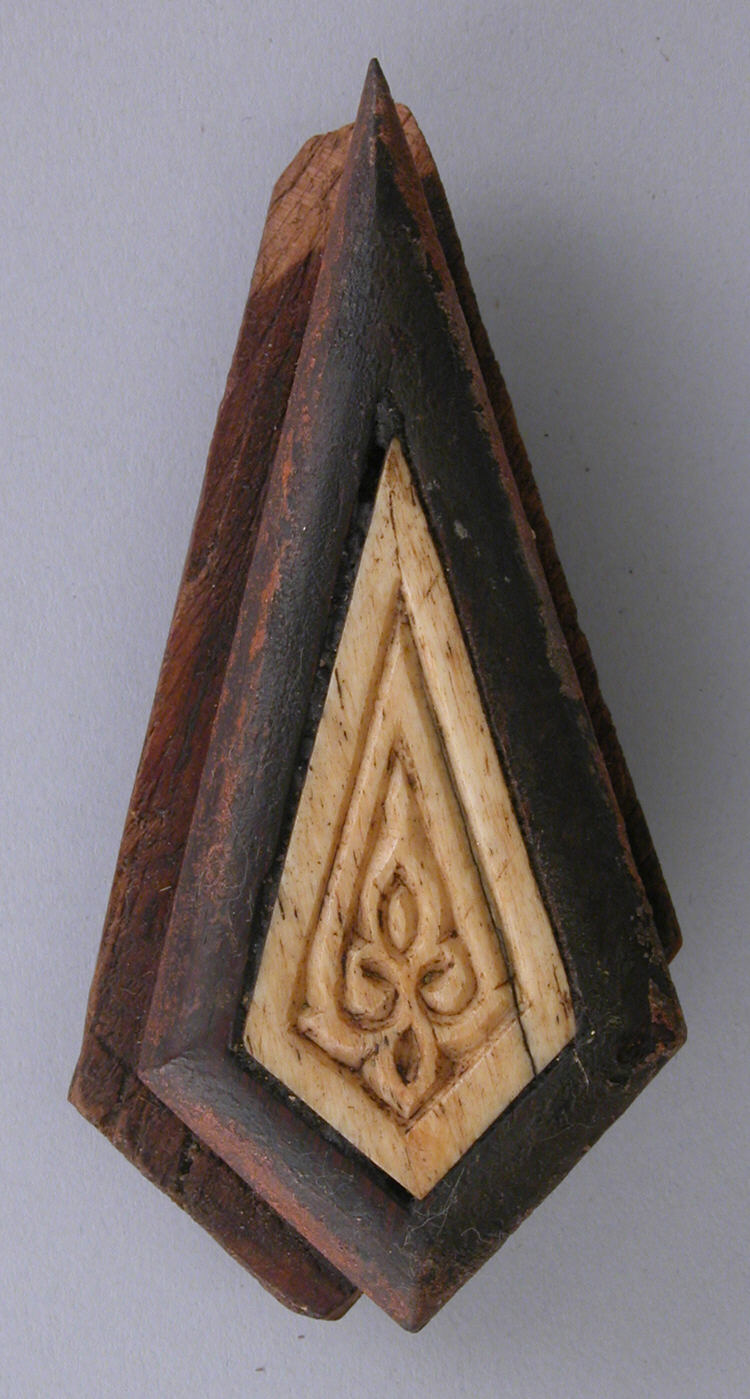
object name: panel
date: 1301-1500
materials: ivory, wood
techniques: carving, inlay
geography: egypt